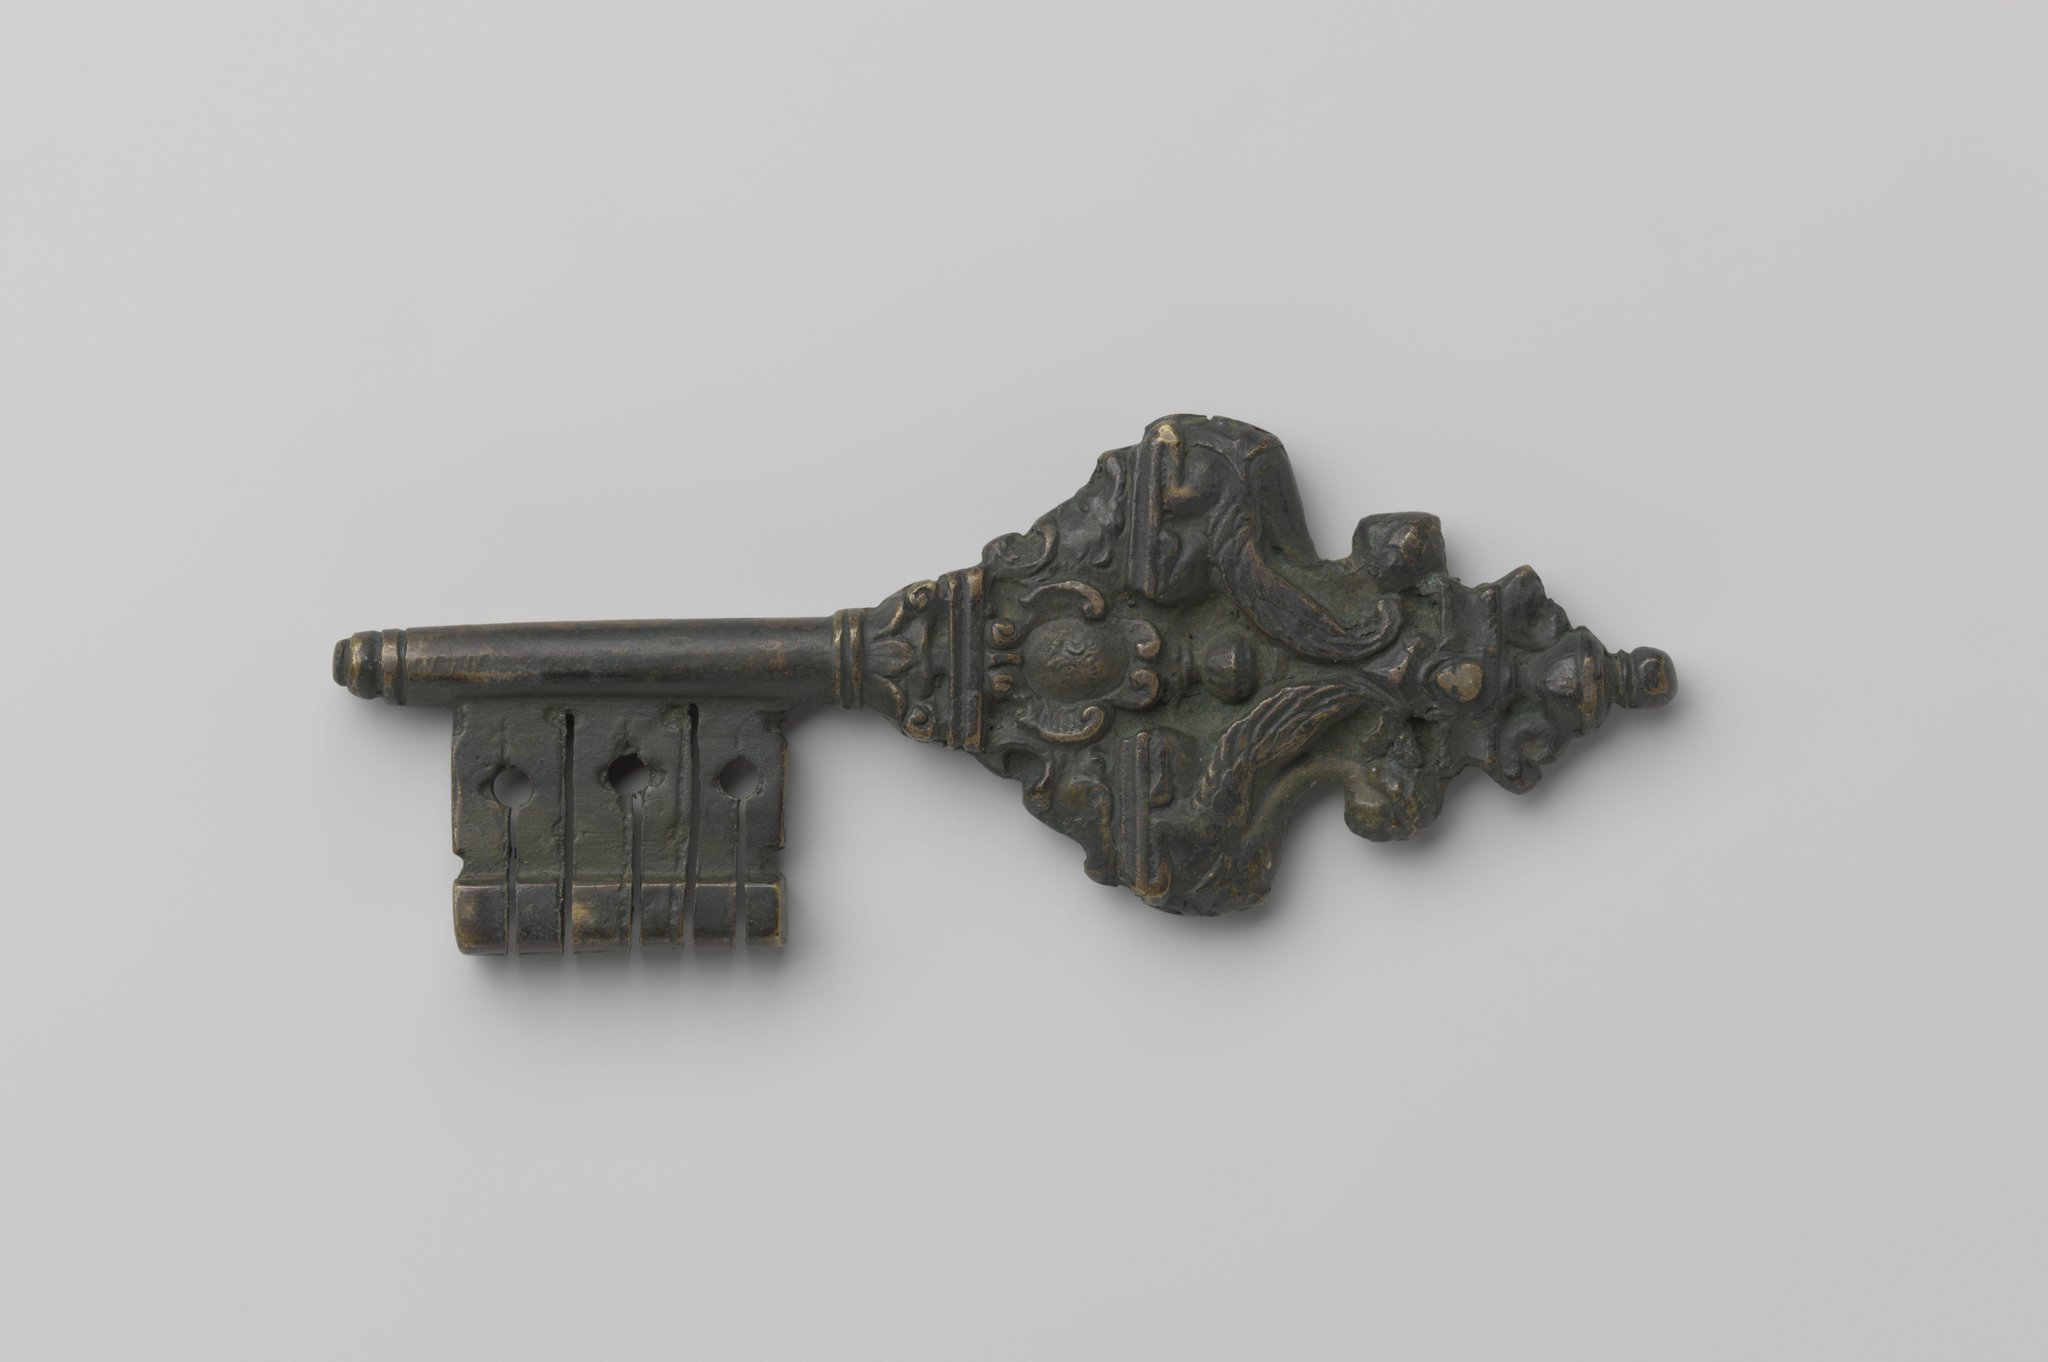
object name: key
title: Sleutel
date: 1600-1625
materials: bronze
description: Sleutel met greep bestaande uit een cartouche tussen twee consoles (gebaarde mannenkoppen), die weer twee ruggelings geplaatste sfinxen dragen, een vaas insluiten en waarboven zich nog een sluitstuk bevindt, bestaande uit een vaas, geflankeerd door twee afgewende dolfijnen. Het geheel rust op een kapiteel van composite orde. De schacht is kort en loopt voorbij de grote baard door en eindigt in een profilering.